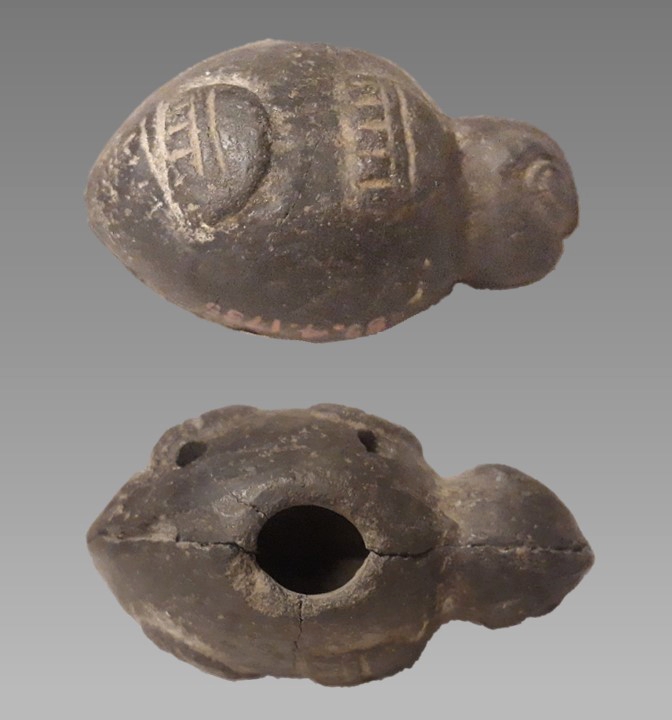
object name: whistle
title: Bird Shaped Whistle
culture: native american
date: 1801-1900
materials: pottery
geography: united states